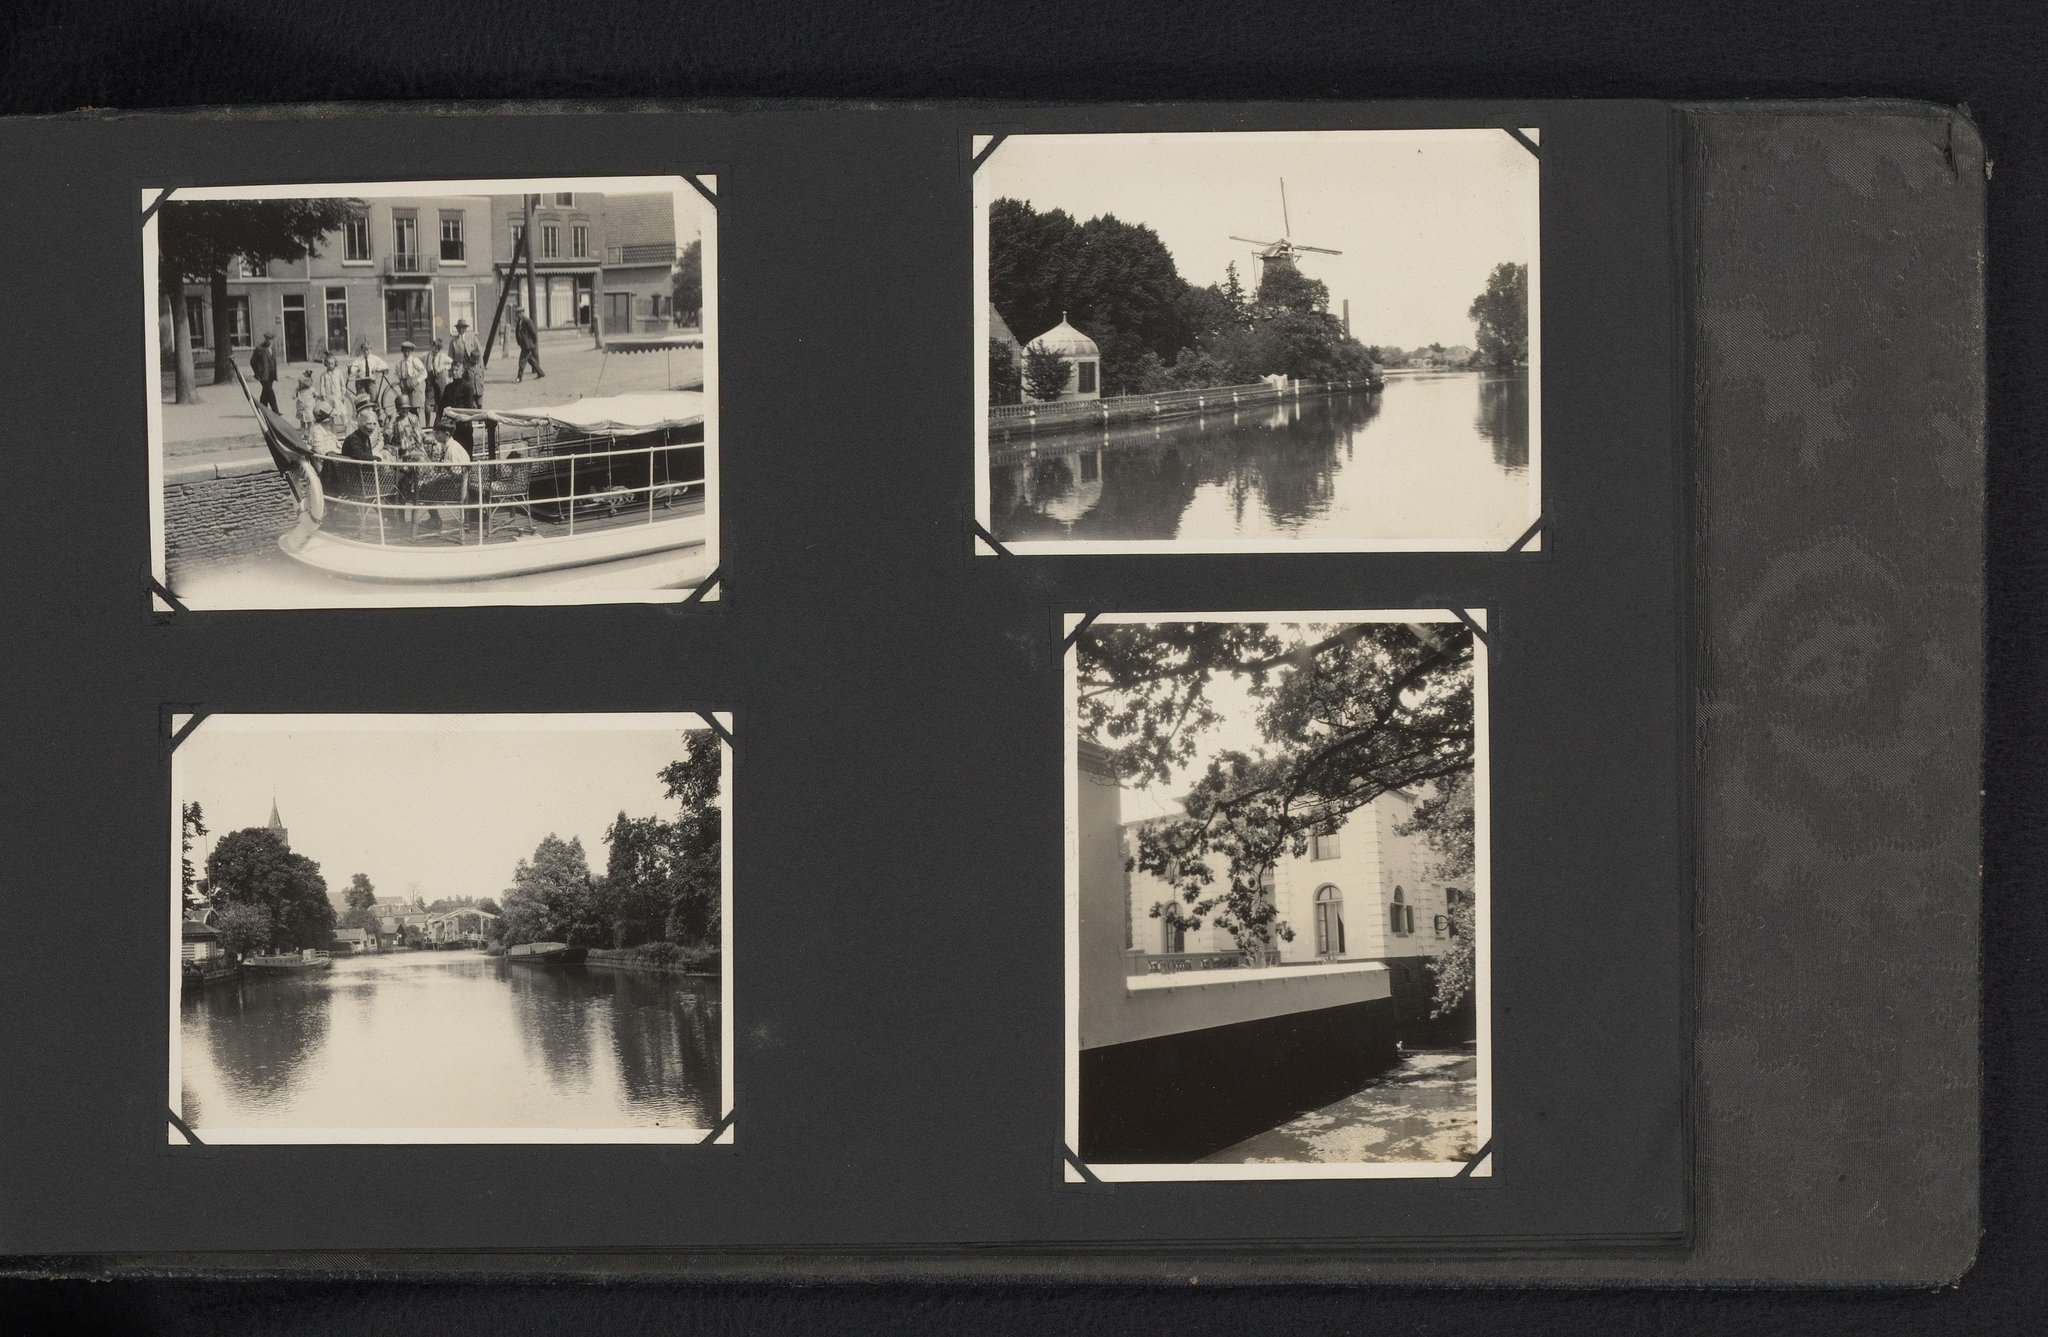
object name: album leaf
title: Vier foto's van een boottocht en een buitenhuis in Nederland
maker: hendrik herman van den berg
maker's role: amateurfotograaf, jurist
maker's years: 1875-1944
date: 1929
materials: paper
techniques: gelatin silver print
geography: netherlands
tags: sailing-ship, sailing-boat, country-house, netherlands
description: Deze foto's maken deel uit van een album.